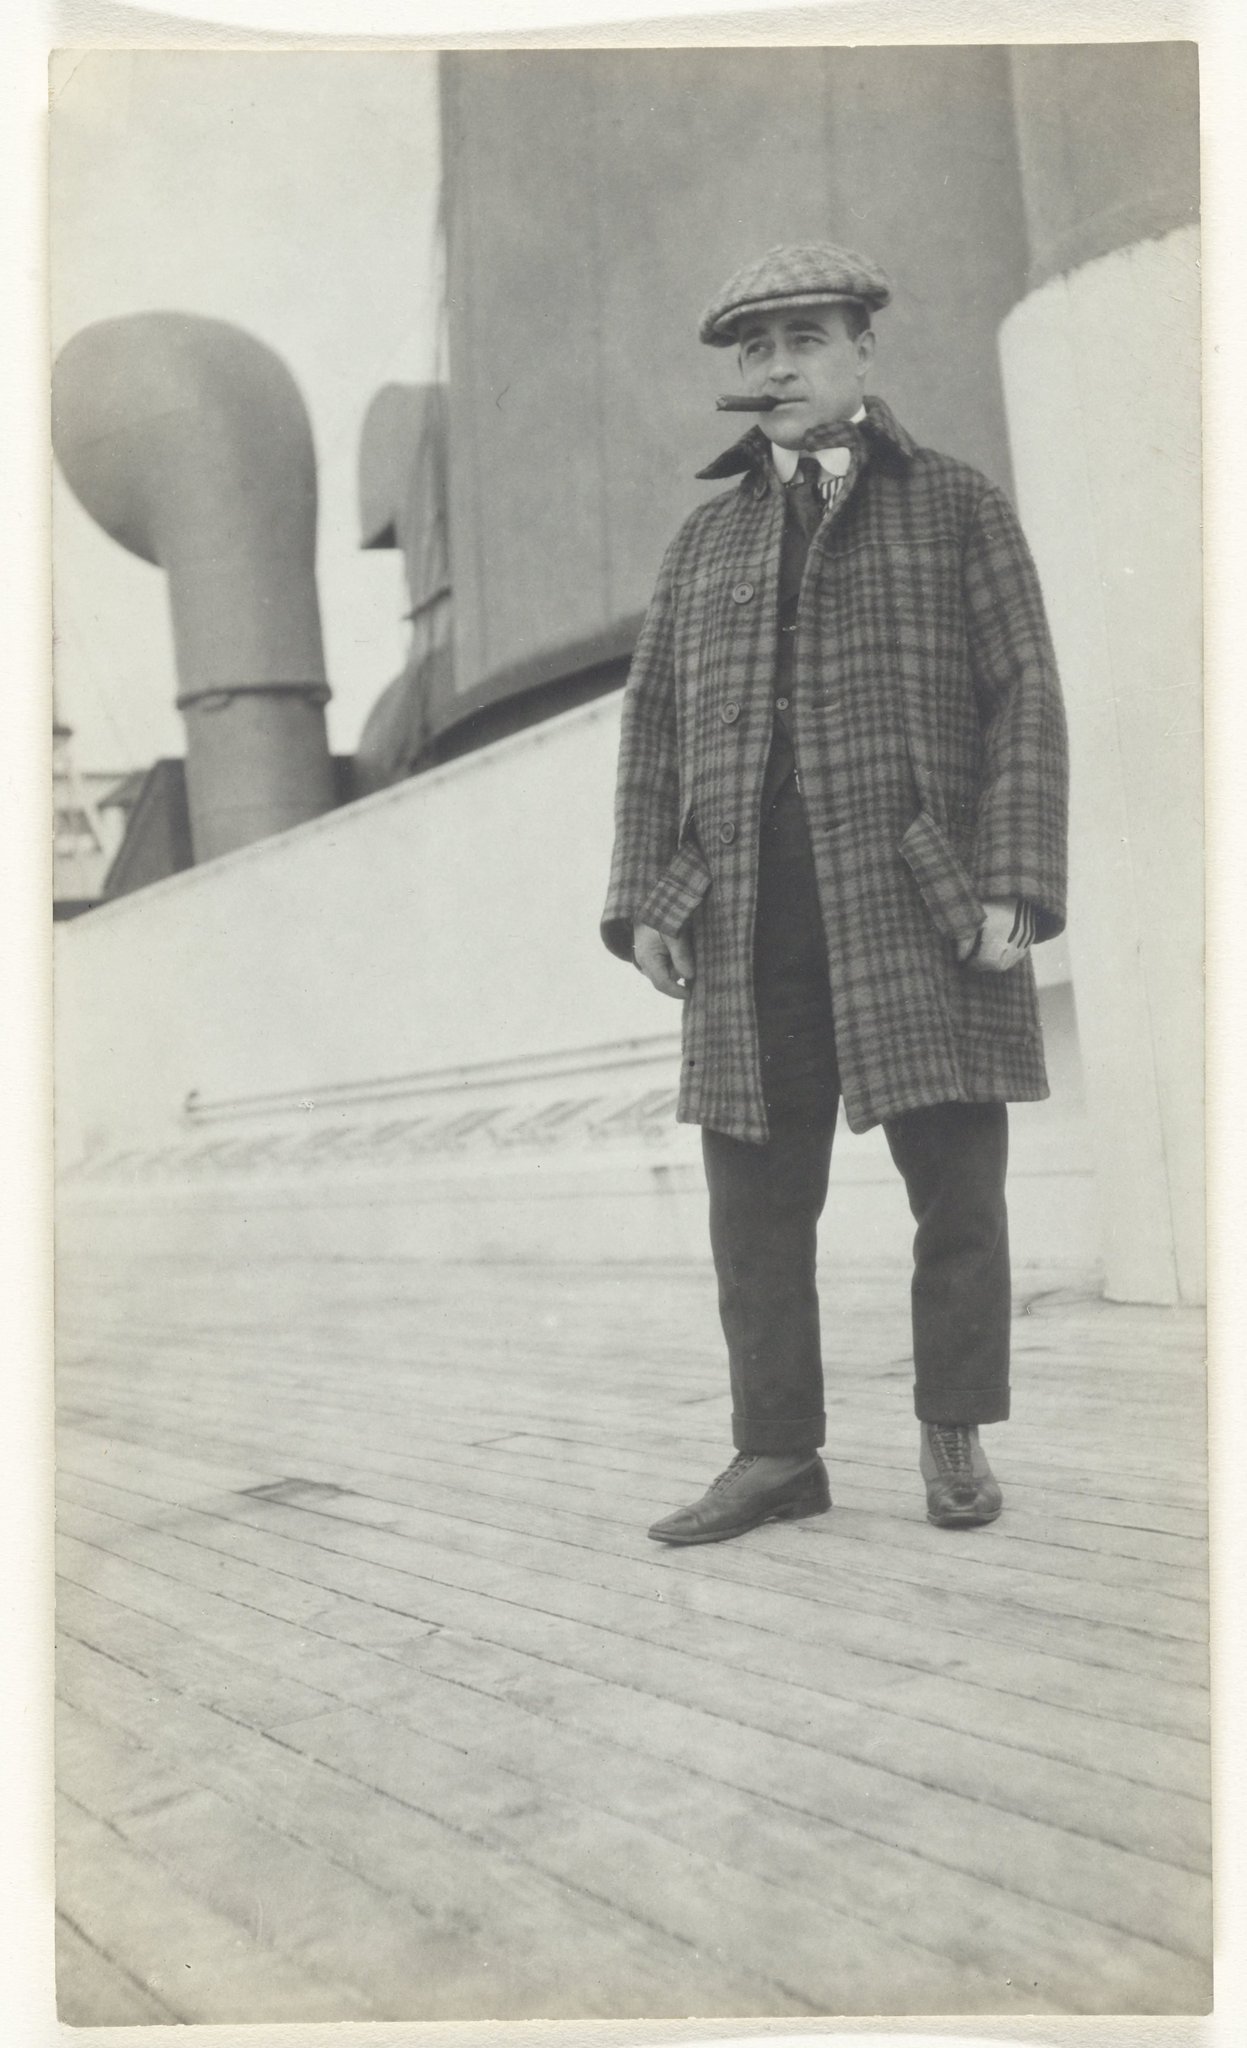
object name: photograph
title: aan boord van schip naar New York in Eerste Wereldoorlog, filmer aan dek, de 'kino-koning' met pet en sigaar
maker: Anonymous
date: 1914-1918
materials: paper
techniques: gelatin silver print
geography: netherlands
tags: ships (in general)